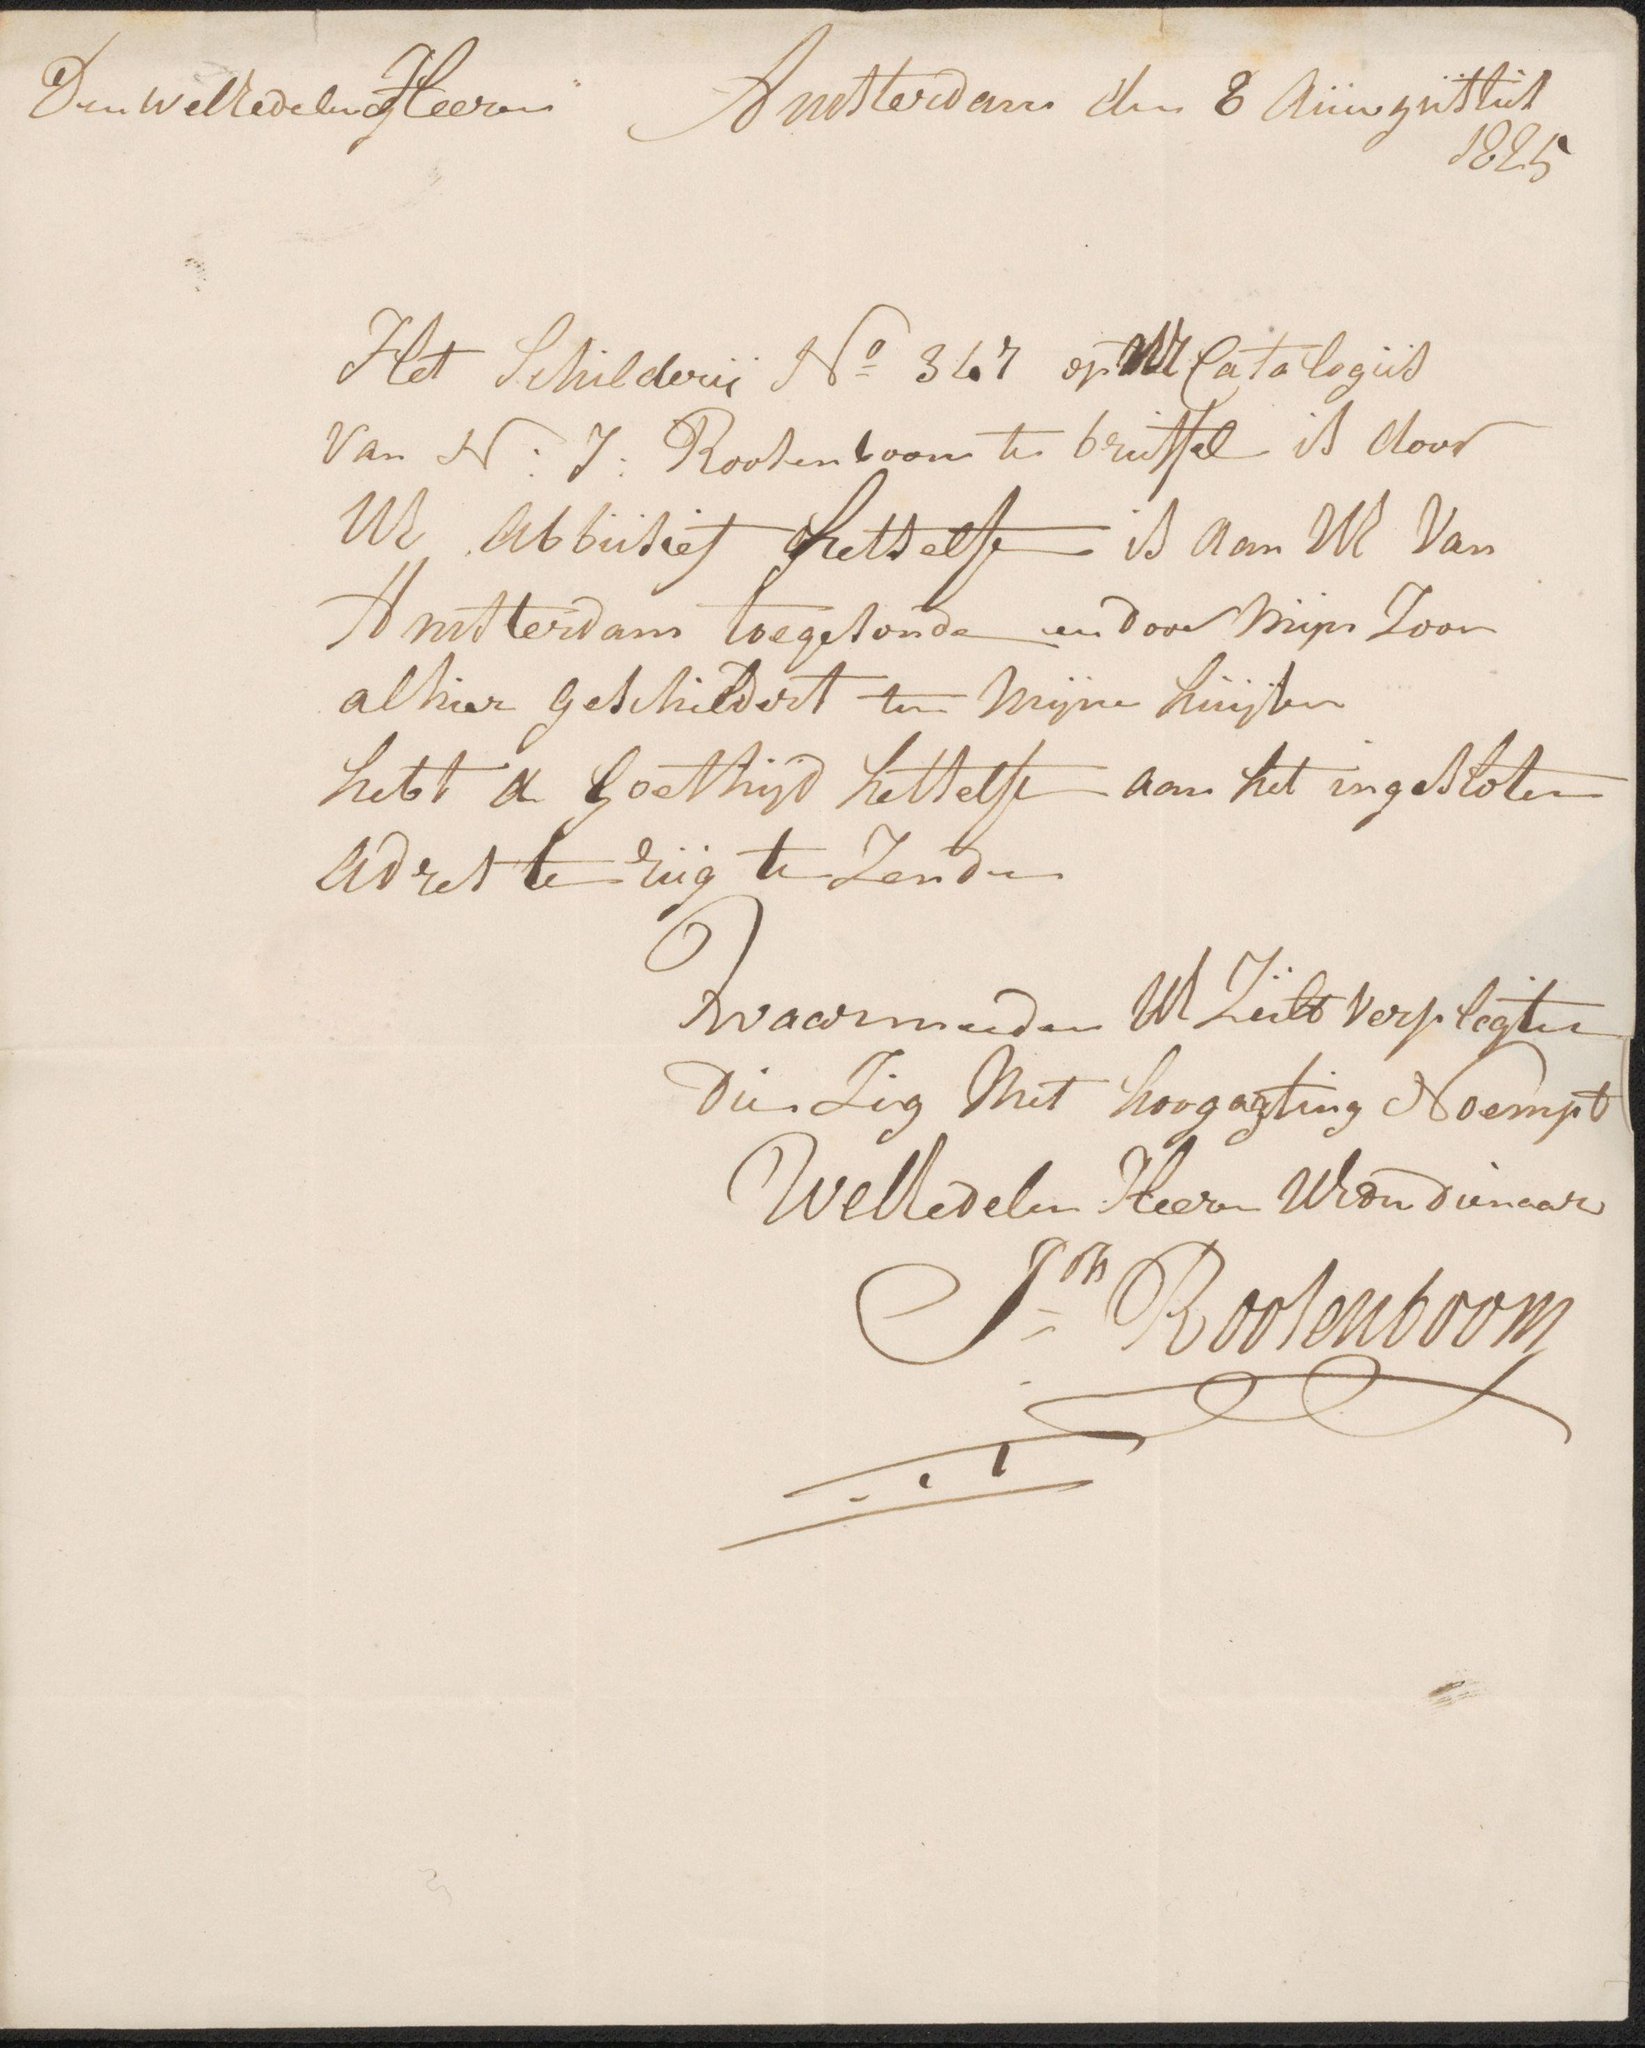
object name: letter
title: Brief aan de Commissie van de Tentoonstelling van Levende Meesters in Haarlem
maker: j. roosenboom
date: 1825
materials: ink, paper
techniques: pen, writing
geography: amsterdam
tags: print maker, draughtsman, nicolaas johannes roosenboom, painting (including book-illumination, miniature-painting), brussels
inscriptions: seal